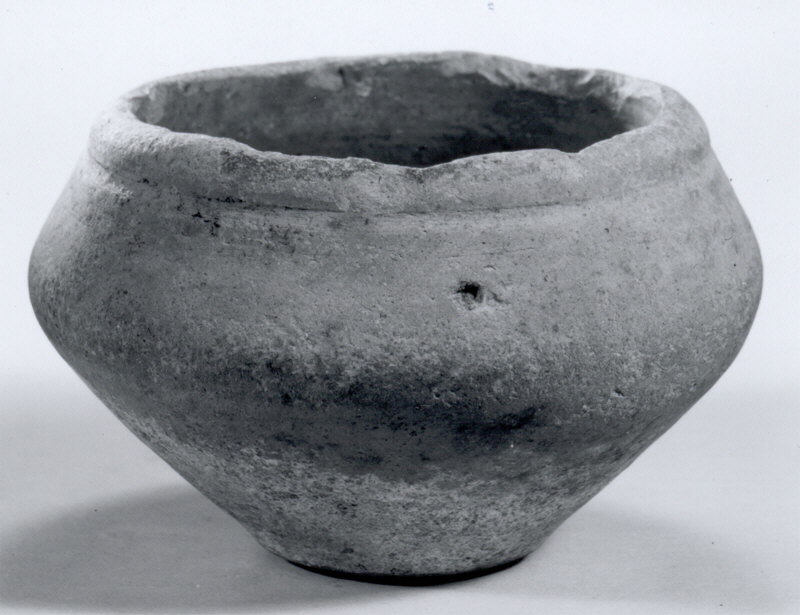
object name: bowl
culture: iranian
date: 900-801 BCE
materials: ceramic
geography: iran